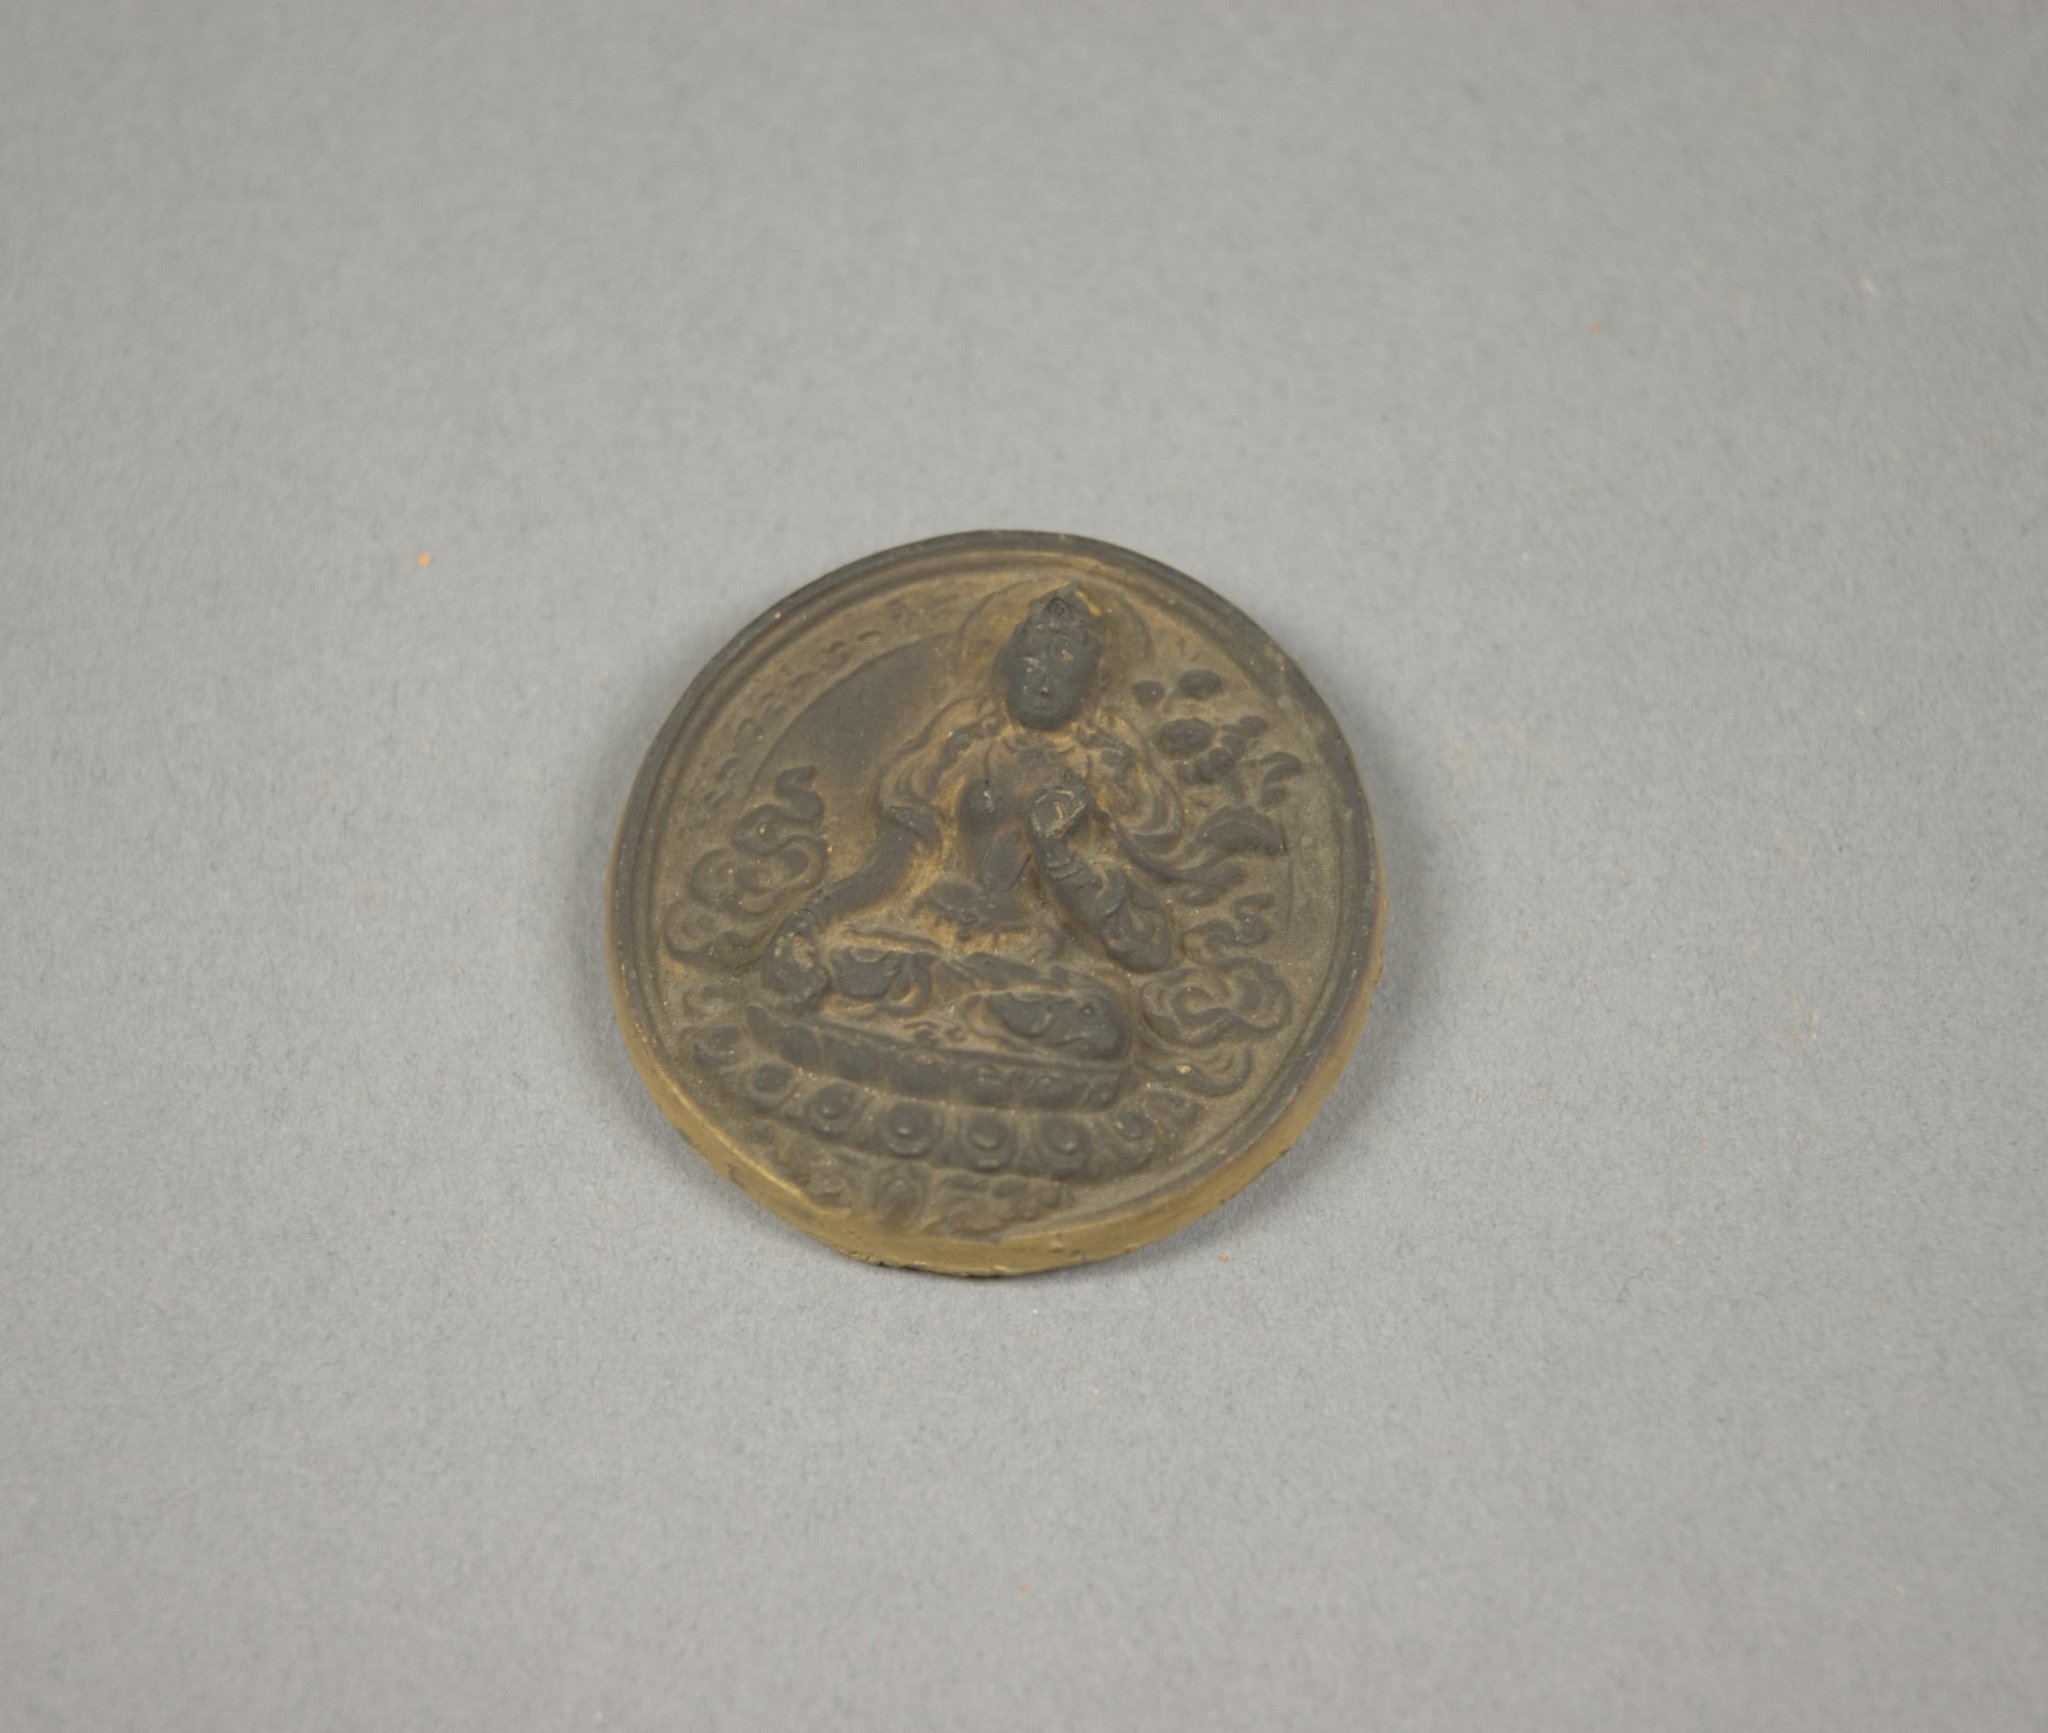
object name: plaque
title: Votive Plaque with White Taras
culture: tibetan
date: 1368-1643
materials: clay